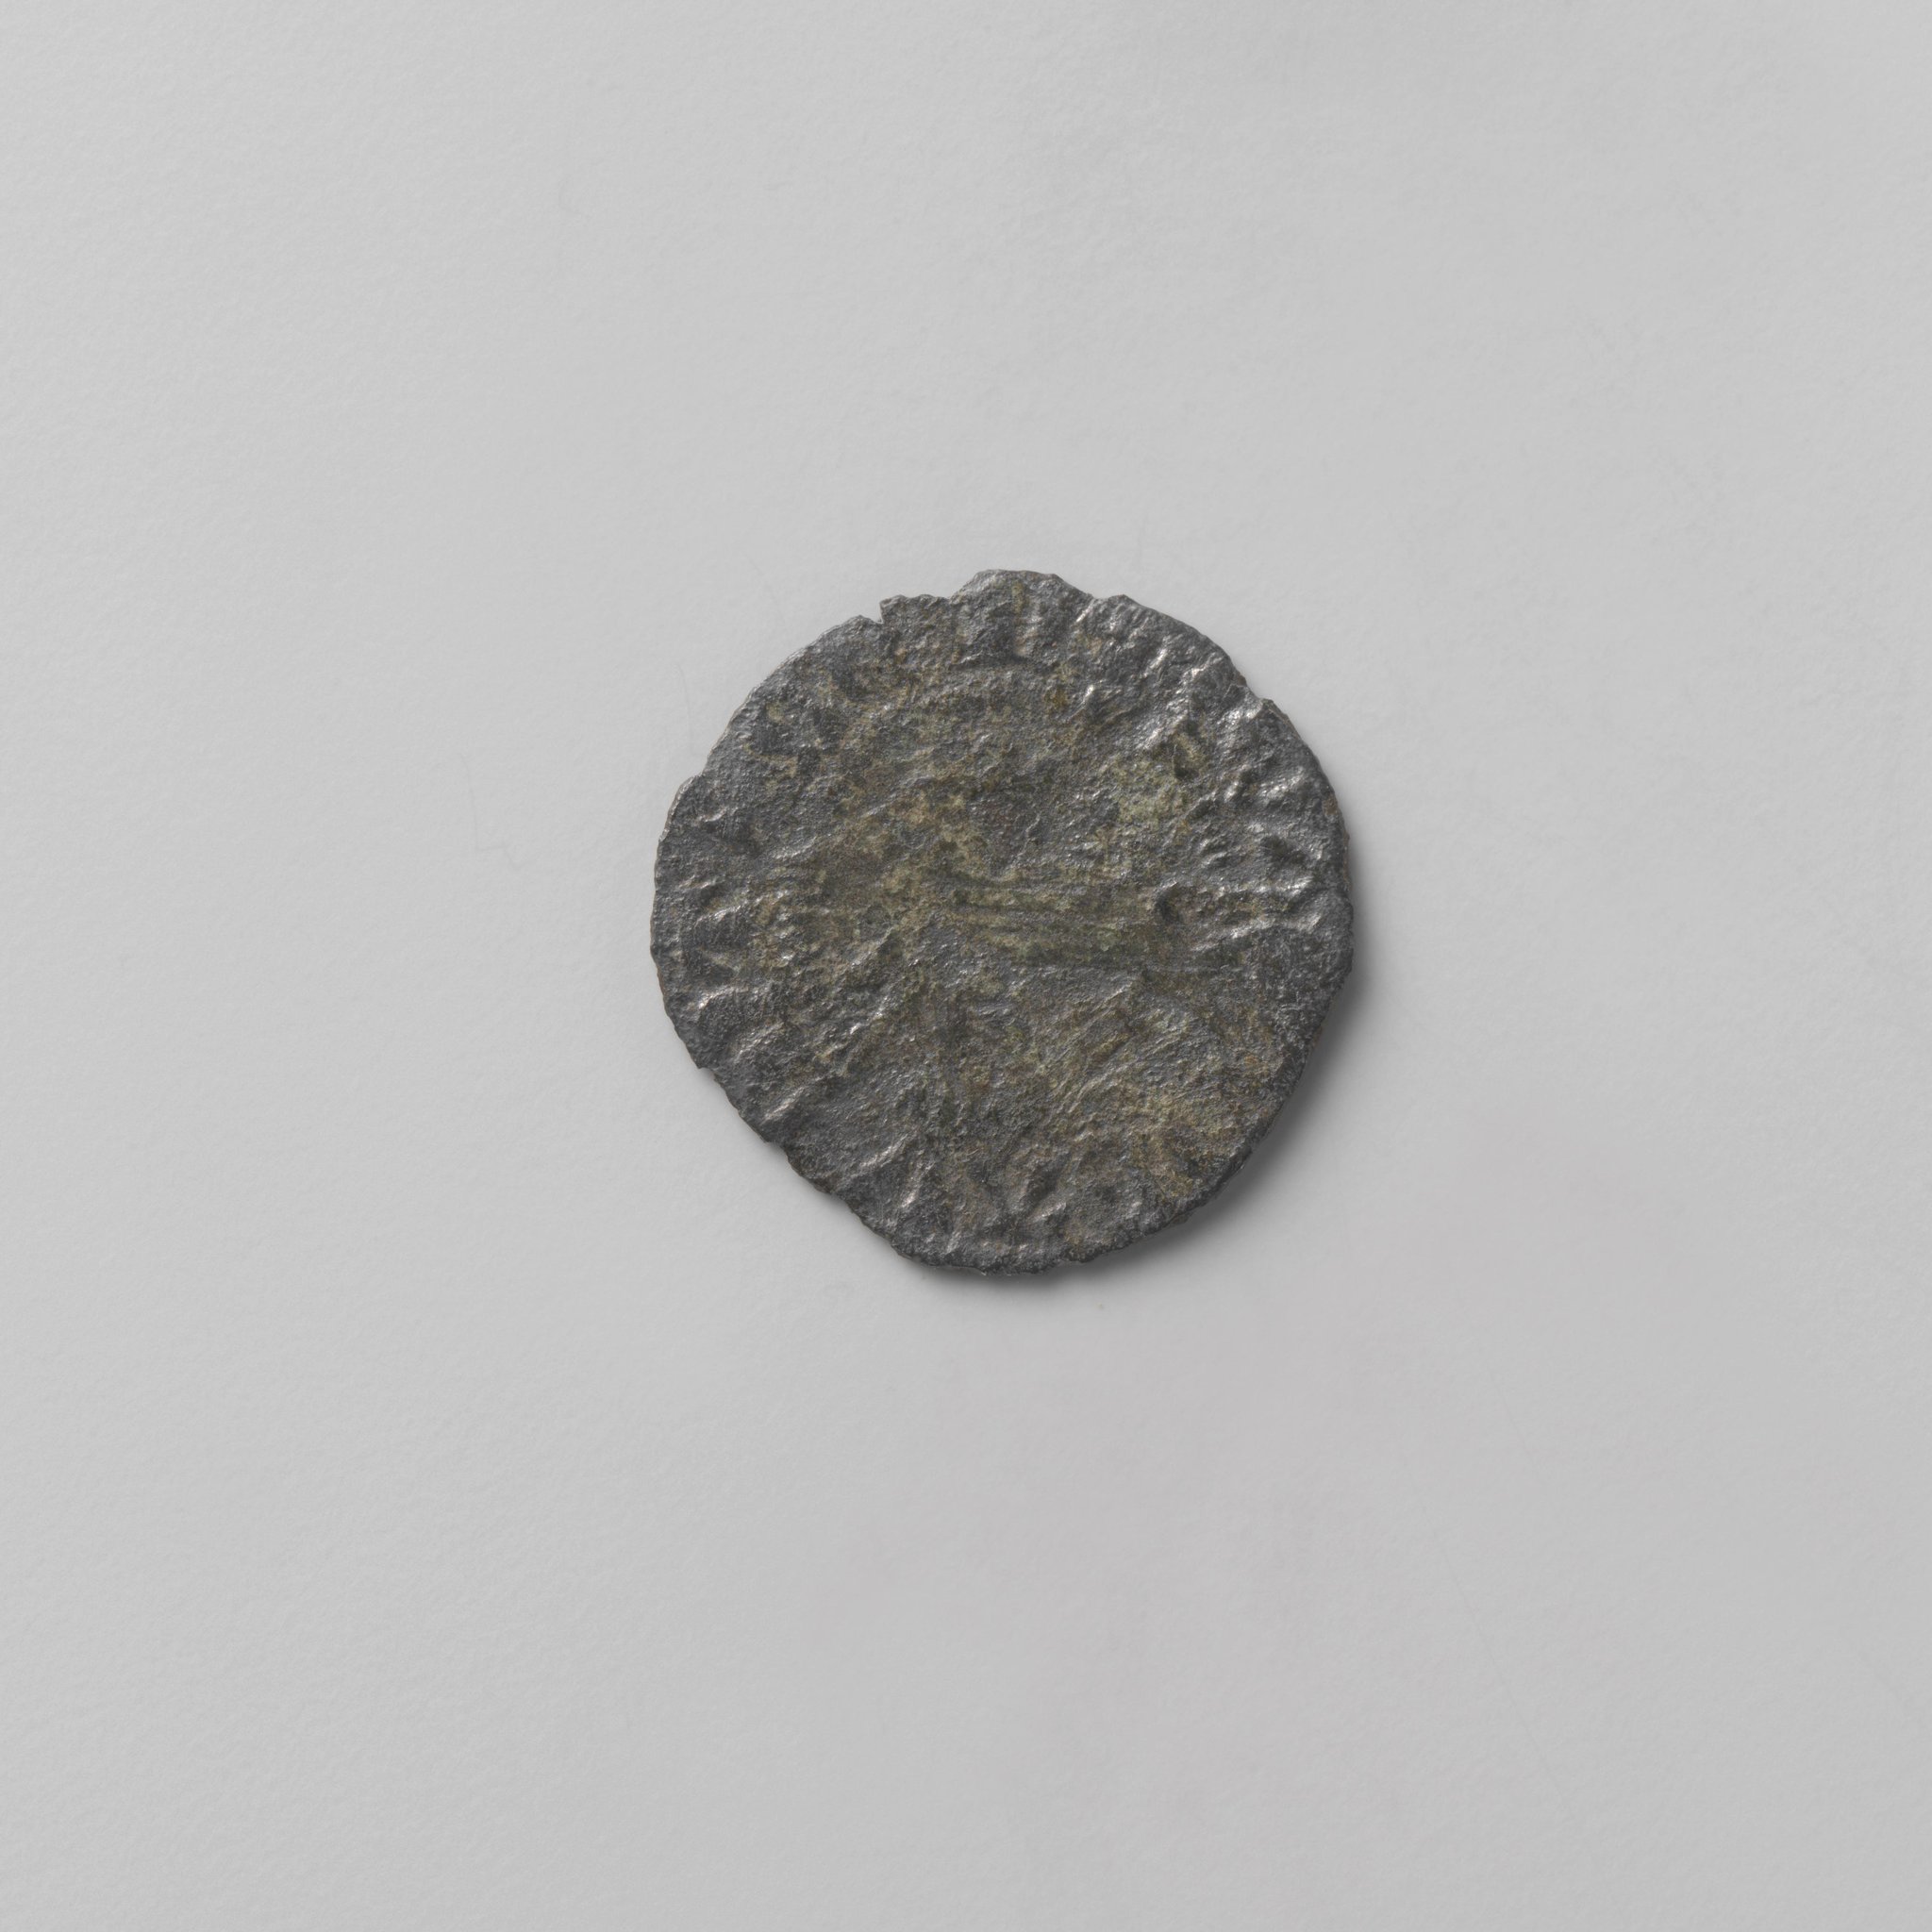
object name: coin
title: Deventer, plak, 1509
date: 1509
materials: silver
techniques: striking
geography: deventer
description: Zilveren munt. Voorzijde: eenkoppige adelaar, waaronder schuin geplaatst wapenschild van Oversticht. Keerzijde: lang gevoet kruis. Jaartal in omschrift.